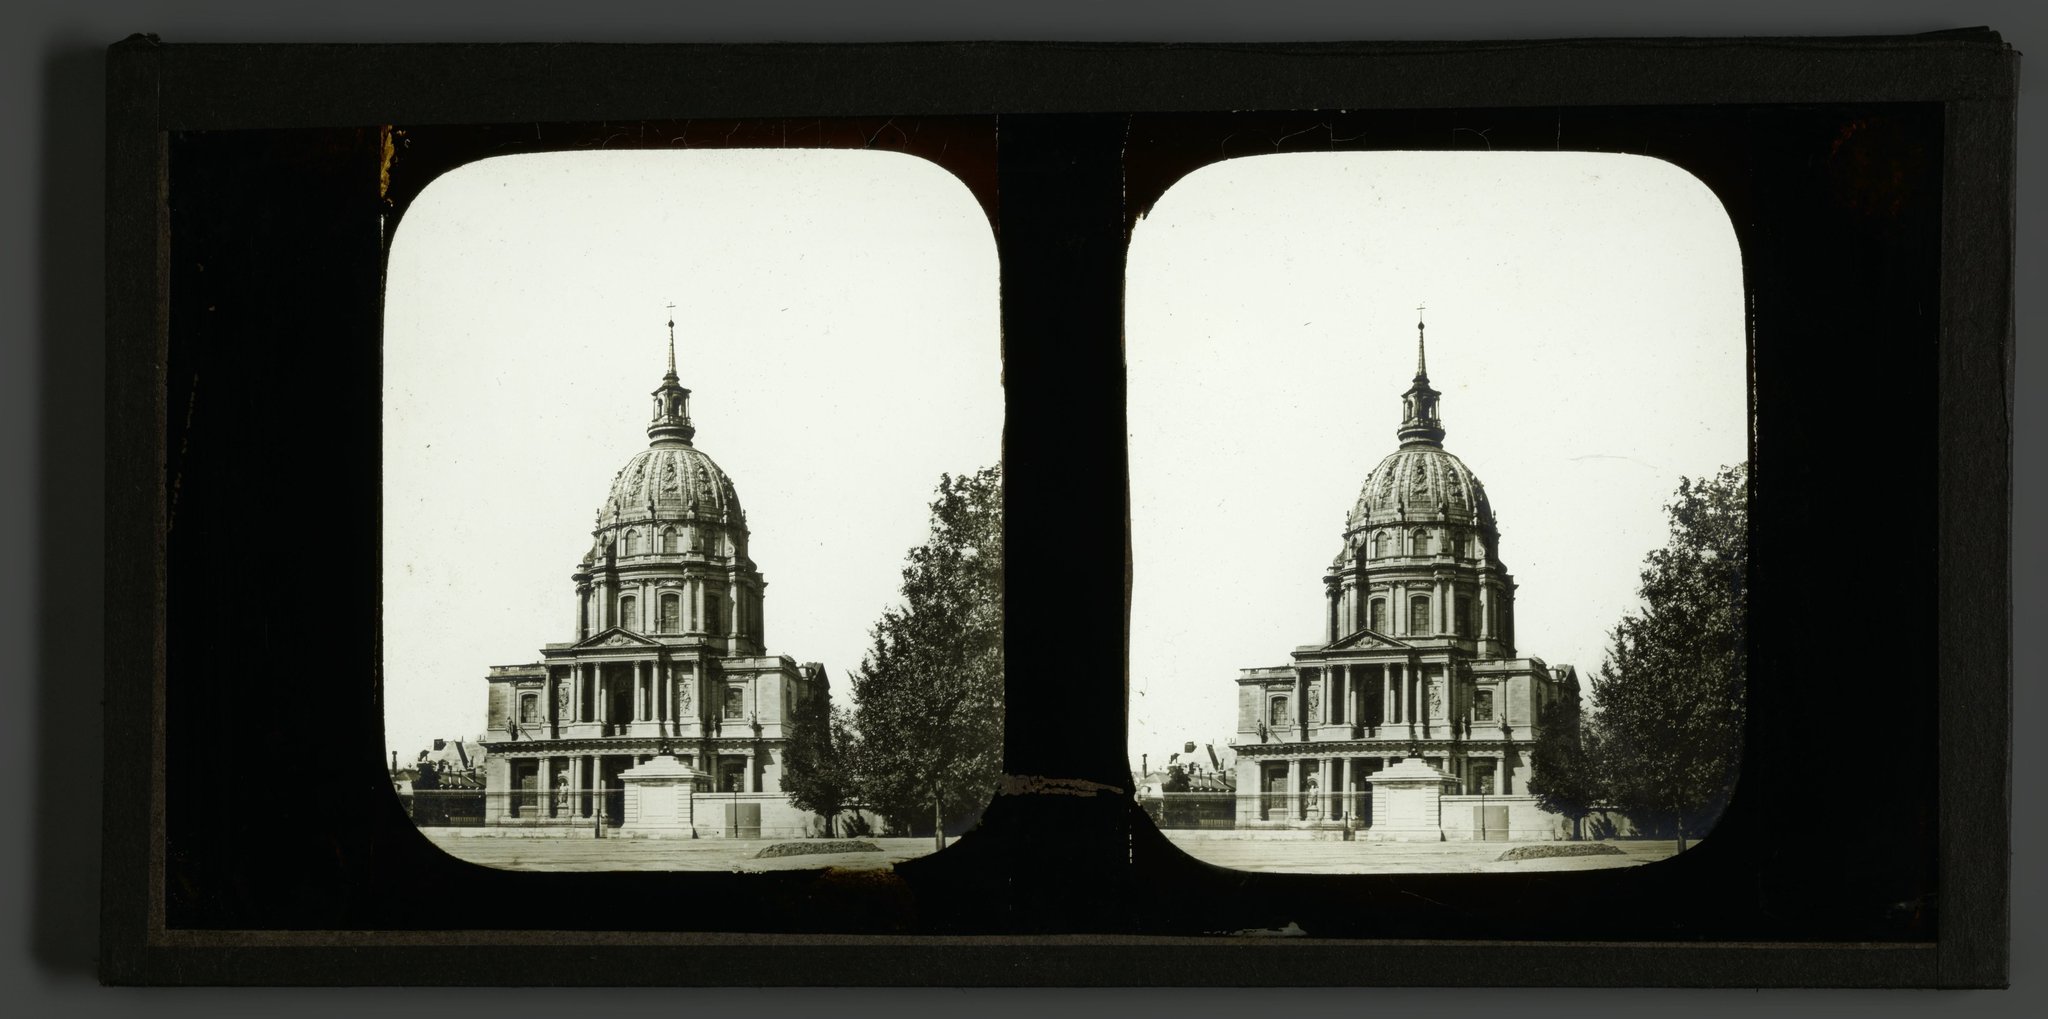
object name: stereoscopic photograph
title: Gezicht op de Dôme des Invalides in Parijs, Frankrijk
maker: Anonymous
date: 1856-1890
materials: glass, paper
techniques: slide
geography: paris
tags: parts of church exterior and annexes: dome